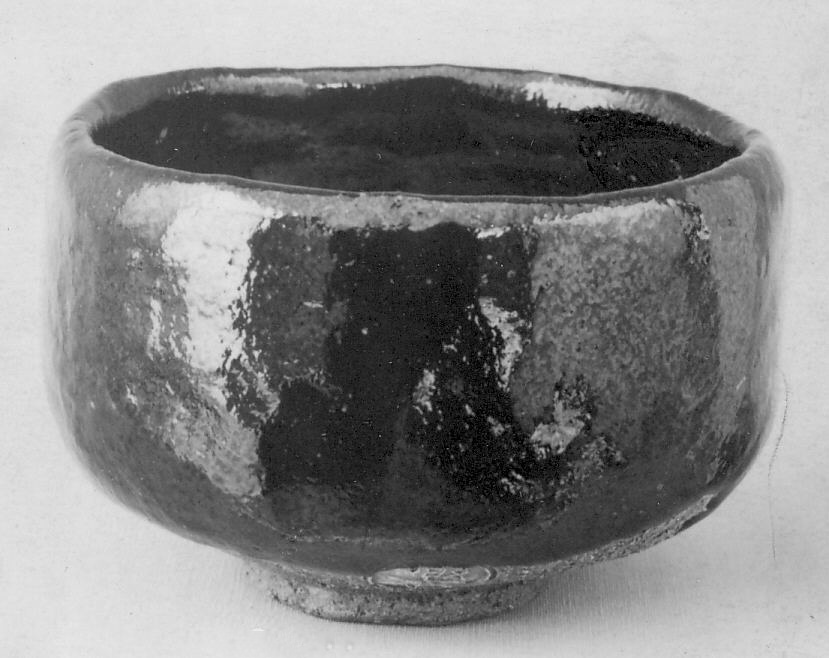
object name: teabowl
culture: japanese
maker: raku tannyu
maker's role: artist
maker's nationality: japanese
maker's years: 1795-1854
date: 1840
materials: clay, glaze